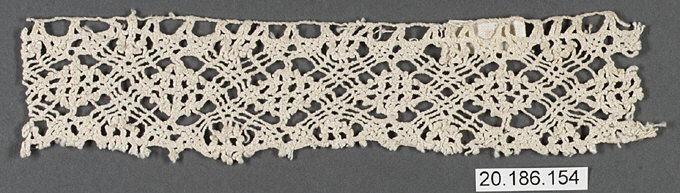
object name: fragment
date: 1501-1600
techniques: lace